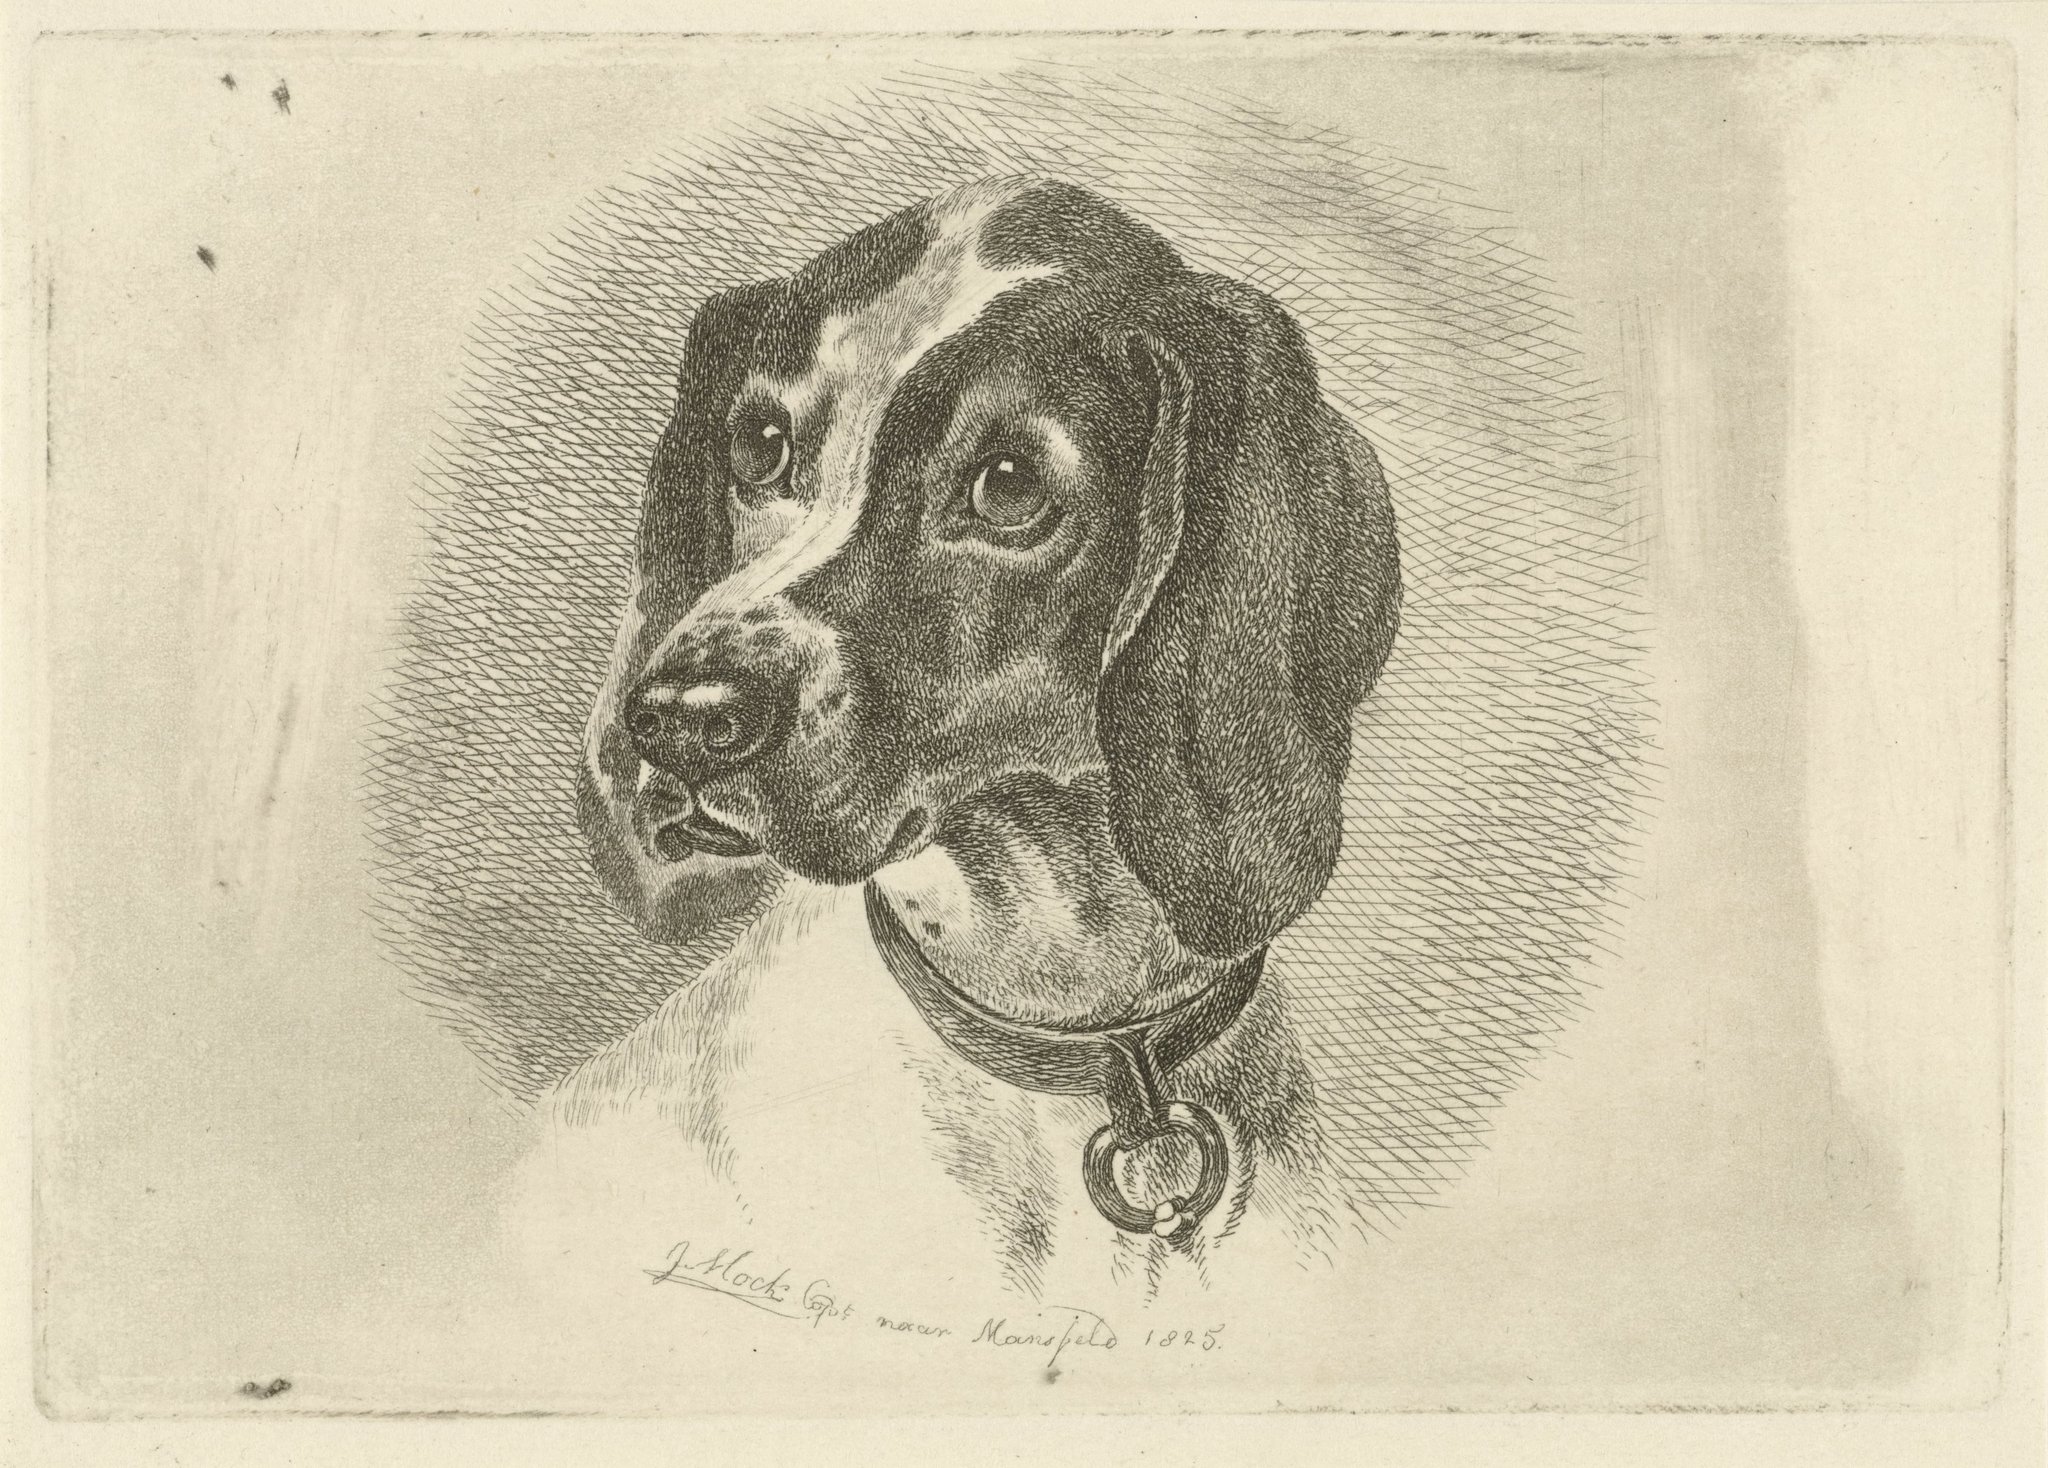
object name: print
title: Hondenkop met een halsband met ring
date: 1825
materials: paper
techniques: aquatint, etching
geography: netherlands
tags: collar (of a dog), dog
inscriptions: collector's mark: Lugt 2228